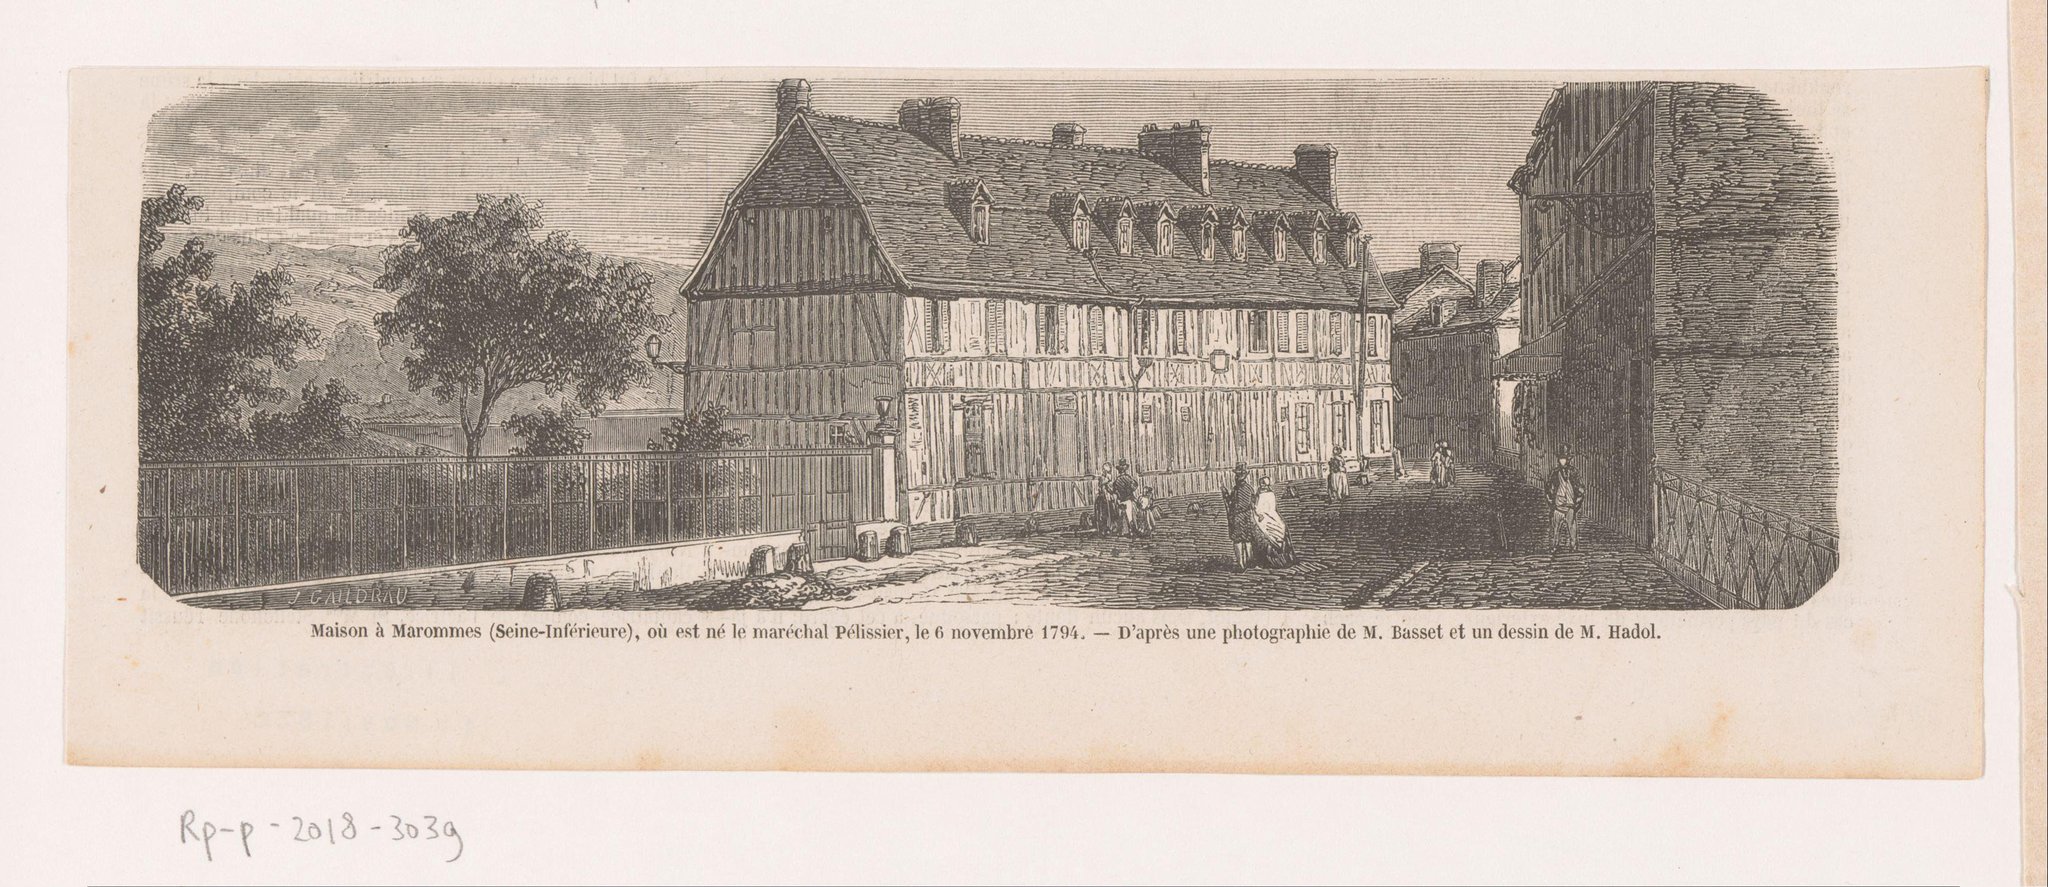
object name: print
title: Gezicht op het geboortehuis van maarschalk Aimable Pélissier in Maromme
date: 1856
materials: paper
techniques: letterpress printing, engraving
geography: paris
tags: urban housing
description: Prent uit: L'Illustration, vol. 28, nr. 716, 15 november 1856, p. 305.